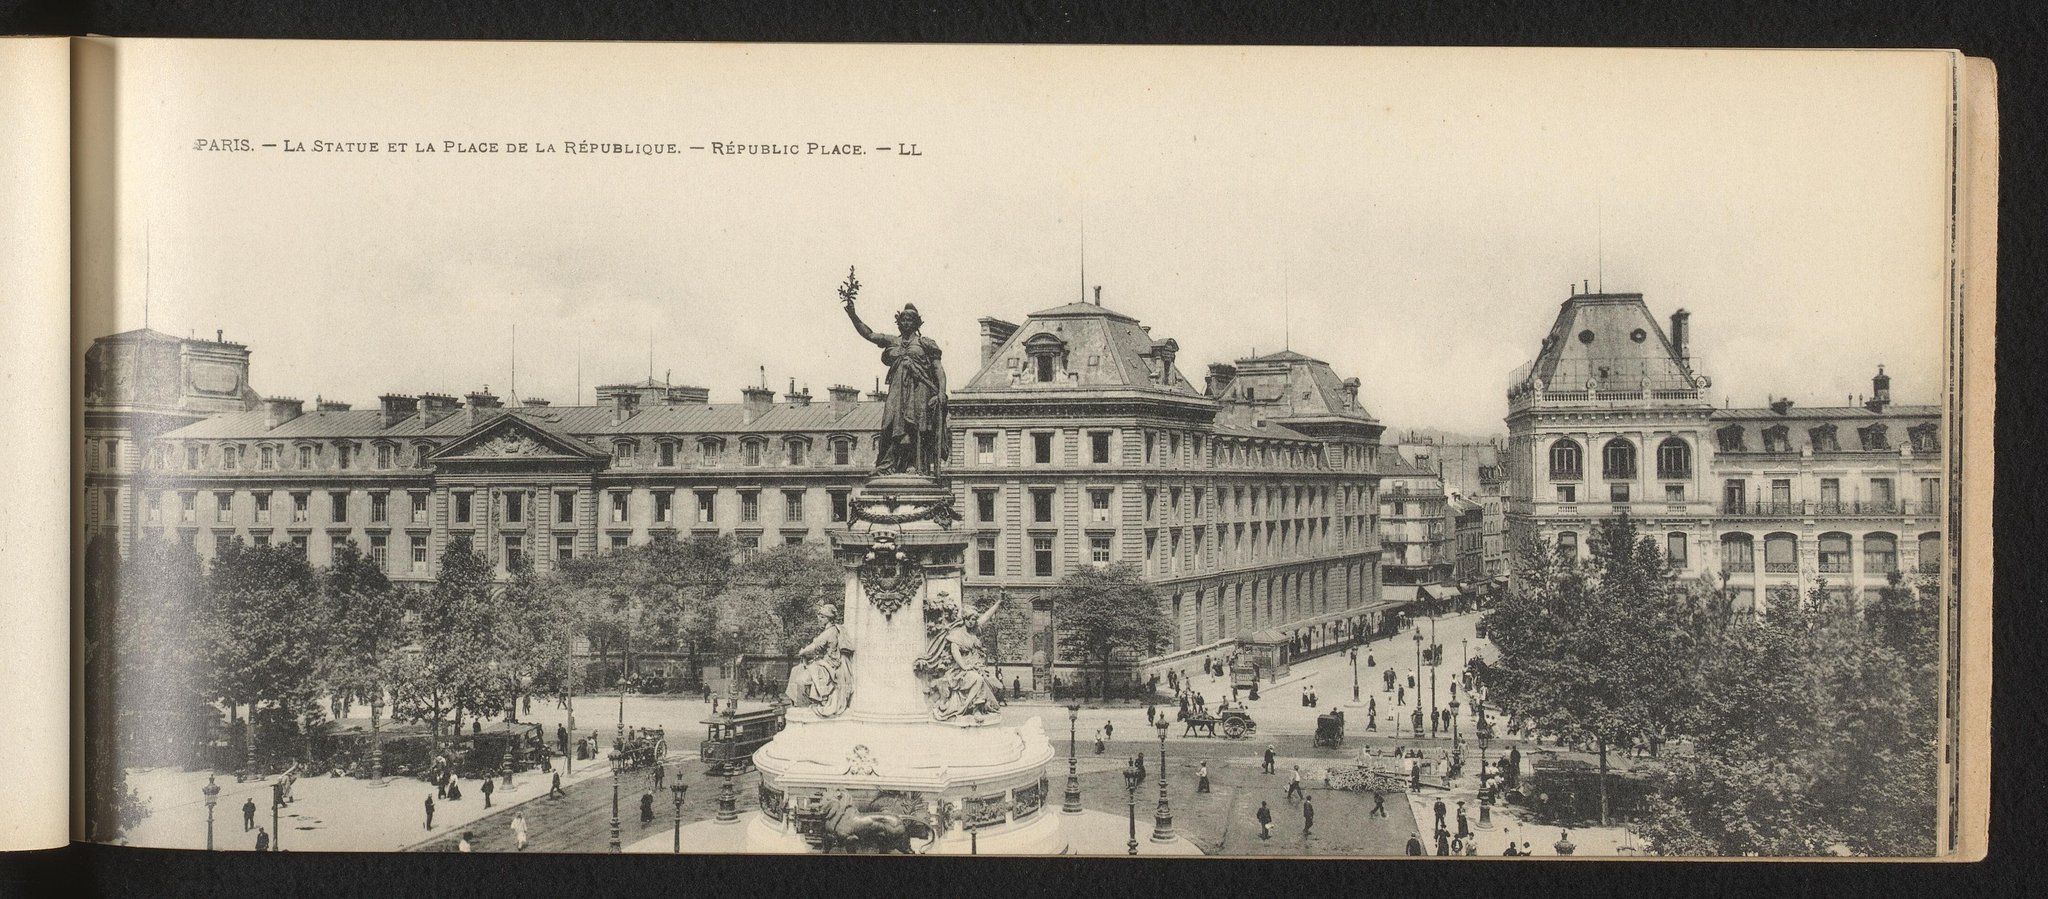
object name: photomechanical print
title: Paris. La Statue et la Place de la République / Républic Place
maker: Anonymous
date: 1920-1932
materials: cardboard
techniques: photograph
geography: paris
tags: monument, statue (+ city(-scape) with figures, staffage), square, place, circus, etc. (+ city(-scape) with figures, staffage)